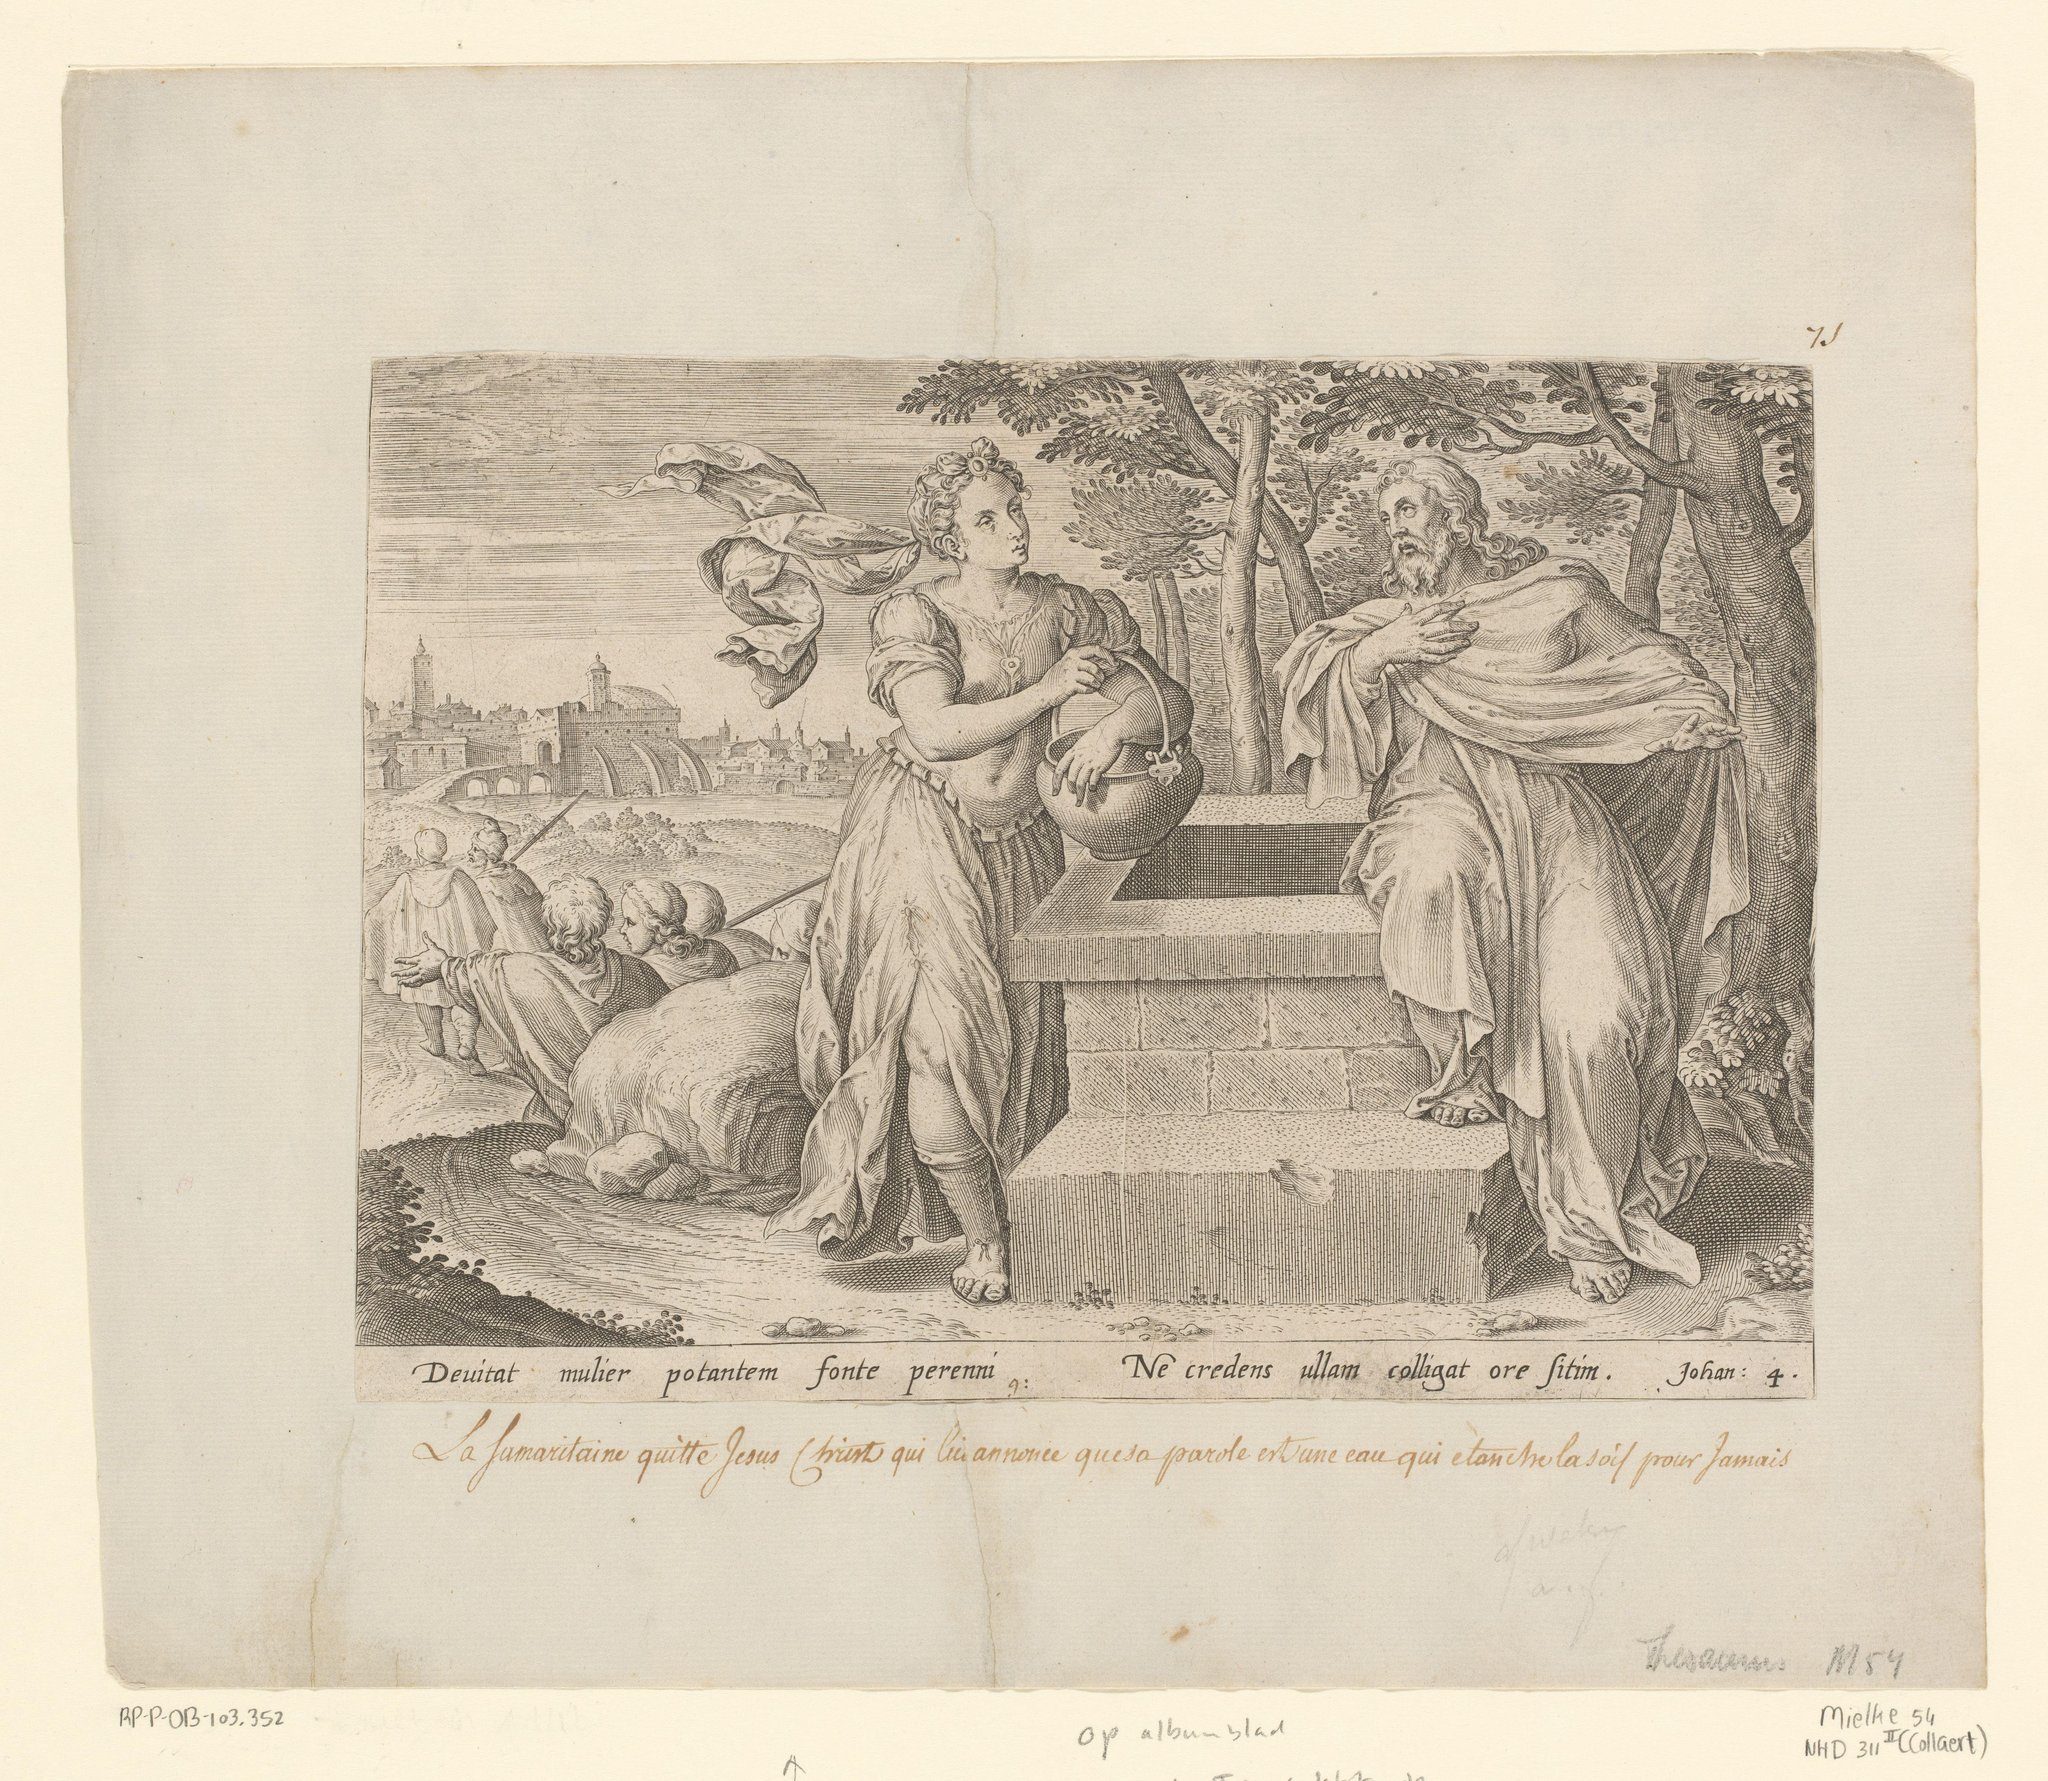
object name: print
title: Bekeringen van zondaars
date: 1585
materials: paper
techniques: engraving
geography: antwerp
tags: christ and the woman of samaria: sitting at jacob's well he asks her for a drink from her jug, christ resting at jacob's well, after having sent his disciples to sychar, utilitarian, public pump or water fountain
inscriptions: inscription: ‘La Samaritaine quitte Jesus Christ (...)’, collector's mark: Lugt 2228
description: Christus rust bij de Jakobsbron, nadat hij zijn discipelen naar de stad heeft gestuurd. Links vertrekken zij richting de stad. Een Samaritaanse vrouw komt om water te putten en spreekt met Christus. Onder de voorstelling een verwijzing in het Latijn naar de Bijbeltekst in Joh. 4.